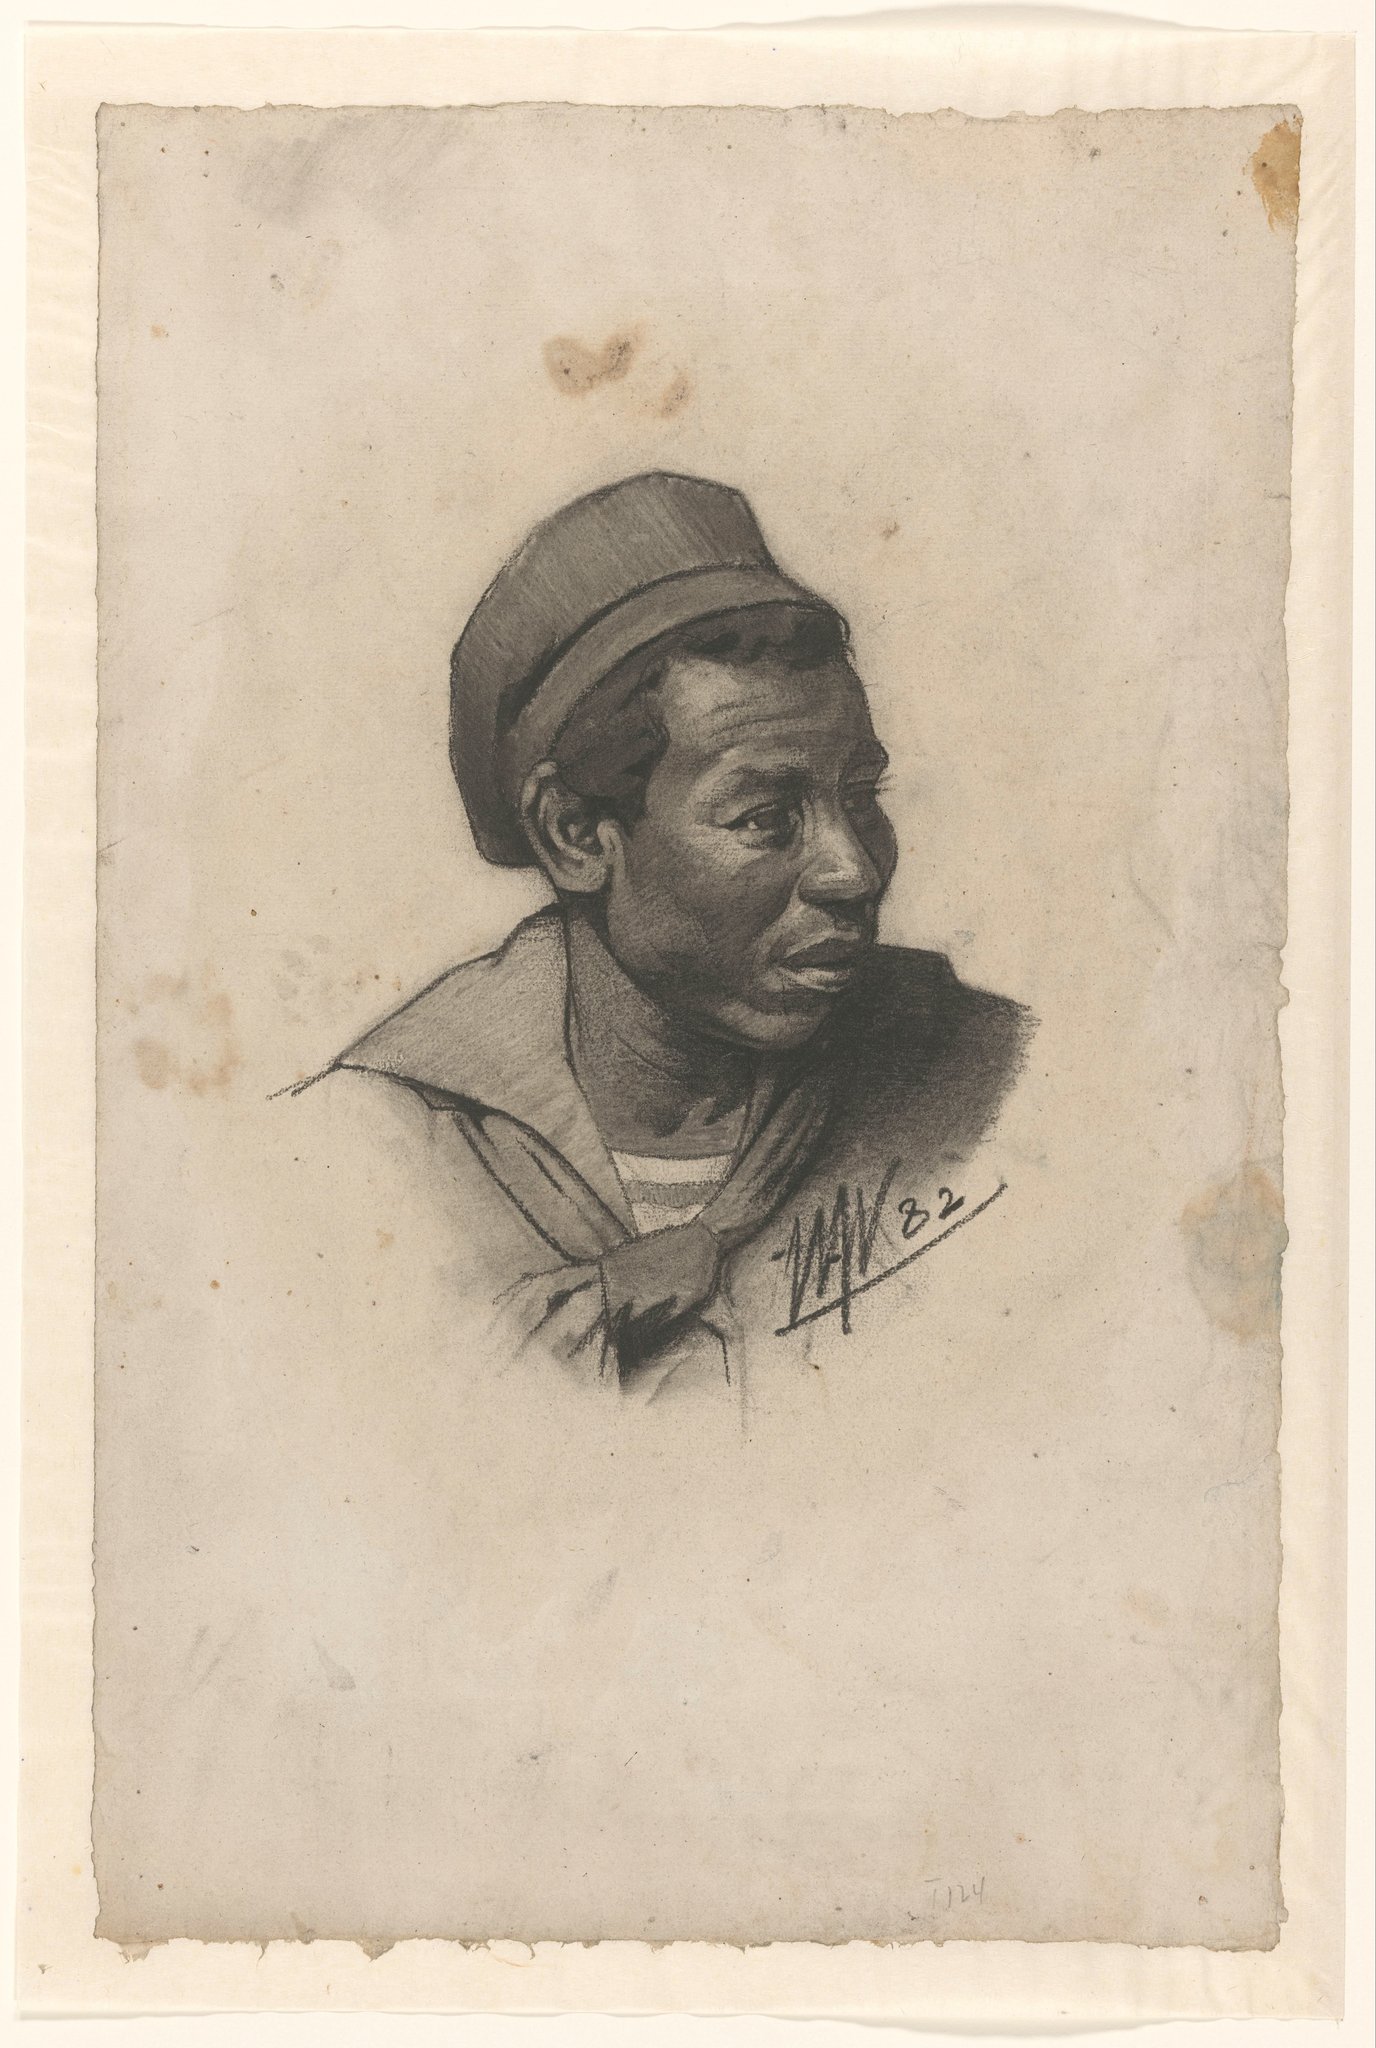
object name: drawing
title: Zwarte Matroos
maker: willem witsen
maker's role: draughtsman, painter, print maker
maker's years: 1860-1923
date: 1882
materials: chalk, paper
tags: africans, anonymous historical person portrayed, seaman: sailor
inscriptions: date: ‘82’